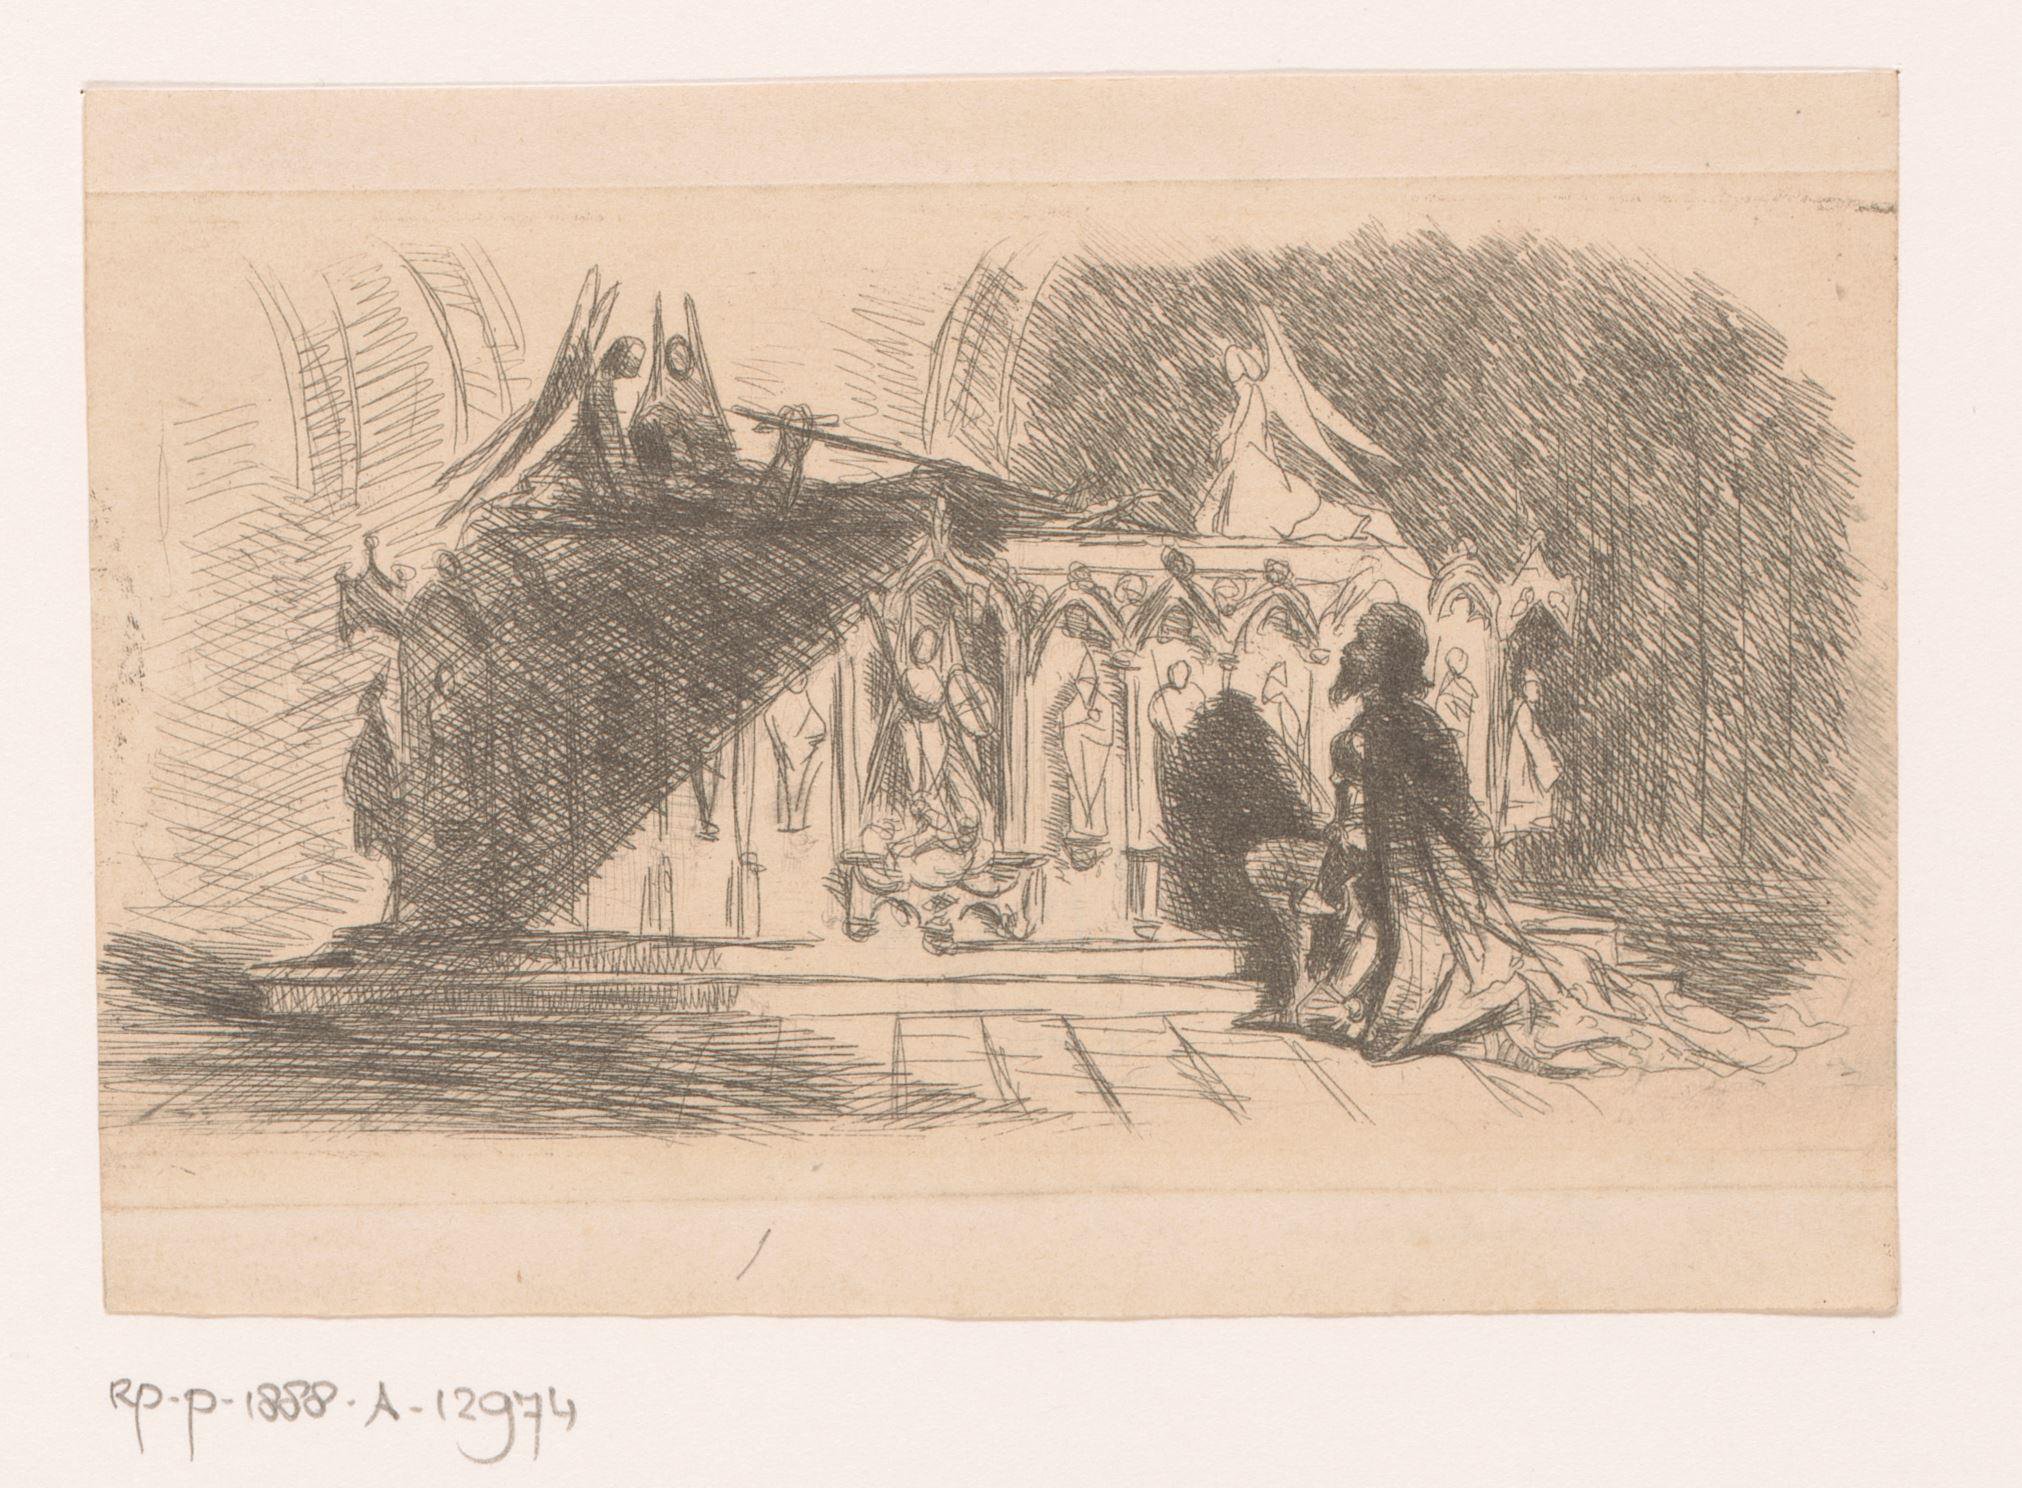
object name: print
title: Man knielt voor een gotische graftombe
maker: gustave buschmann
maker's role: print maker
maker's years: 1818-1852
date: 1840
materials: paper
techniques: etching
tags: grave, tomb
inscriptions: collector's mark: Lugt 2228, annotation: ‘G Buschmann 1 dr.’